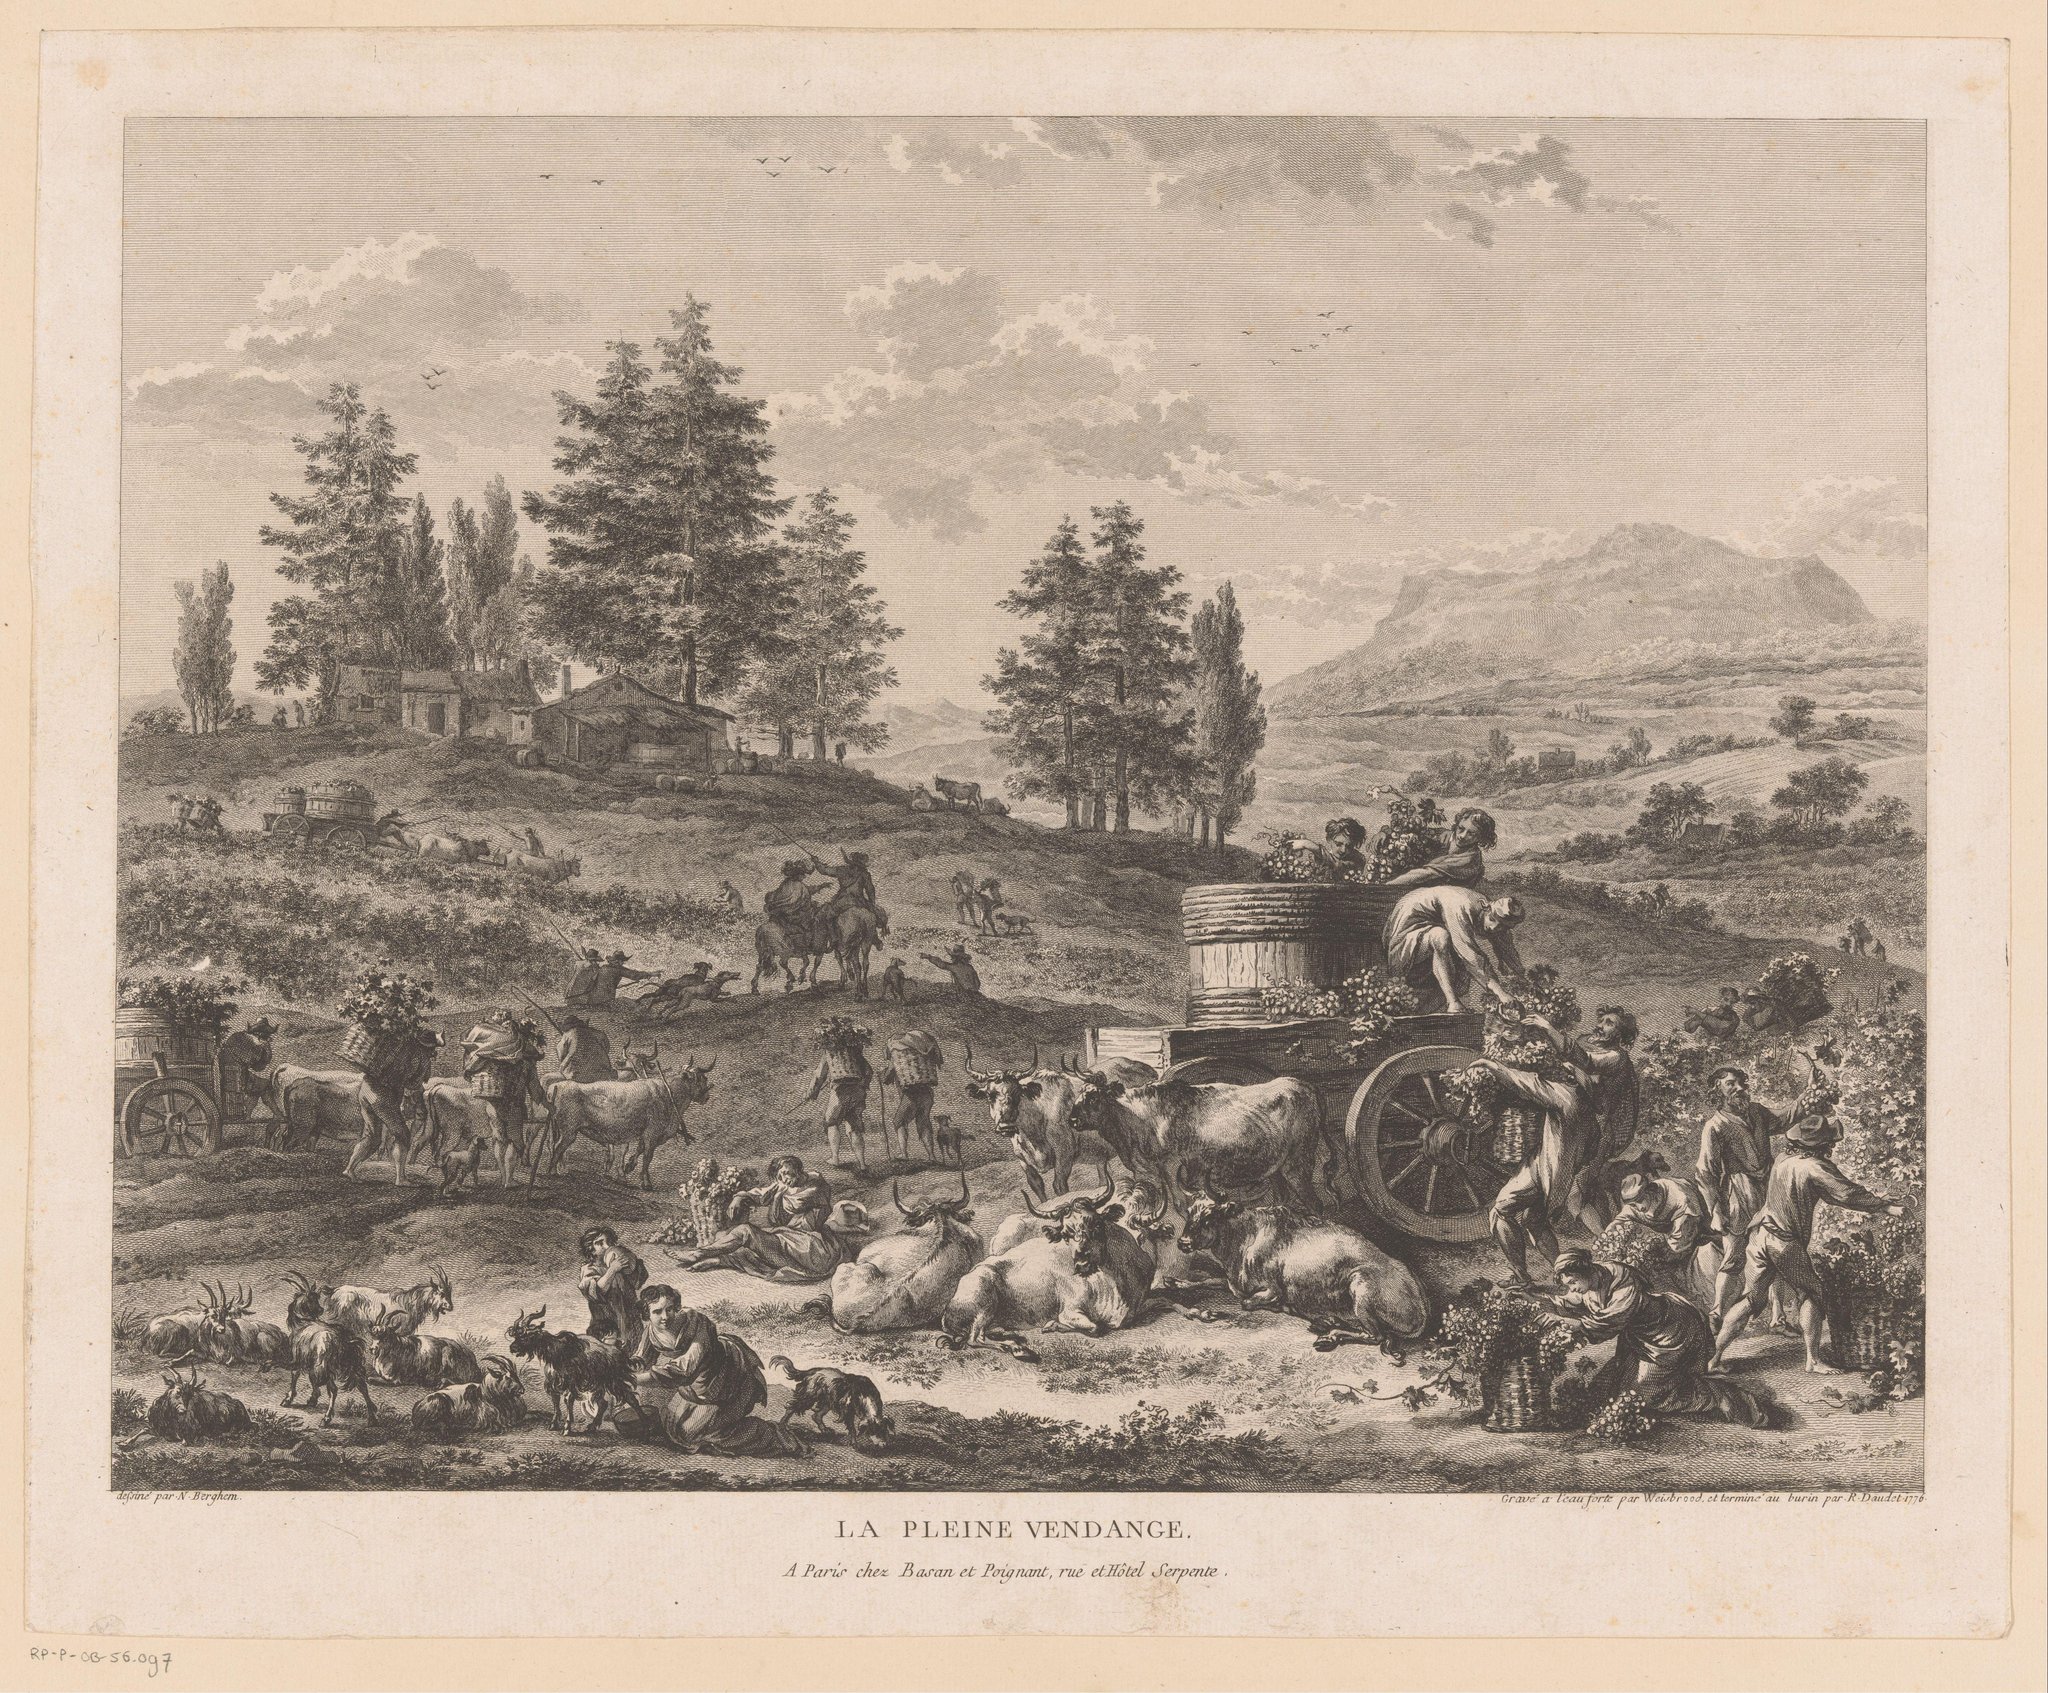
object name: print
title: Wijnoogst in een landschap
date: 1776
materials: paper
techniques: etching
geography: paris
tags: city-view, and landscape with man-made constructions, vintage, grape harvest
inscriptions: collector's mark: Lugt 240